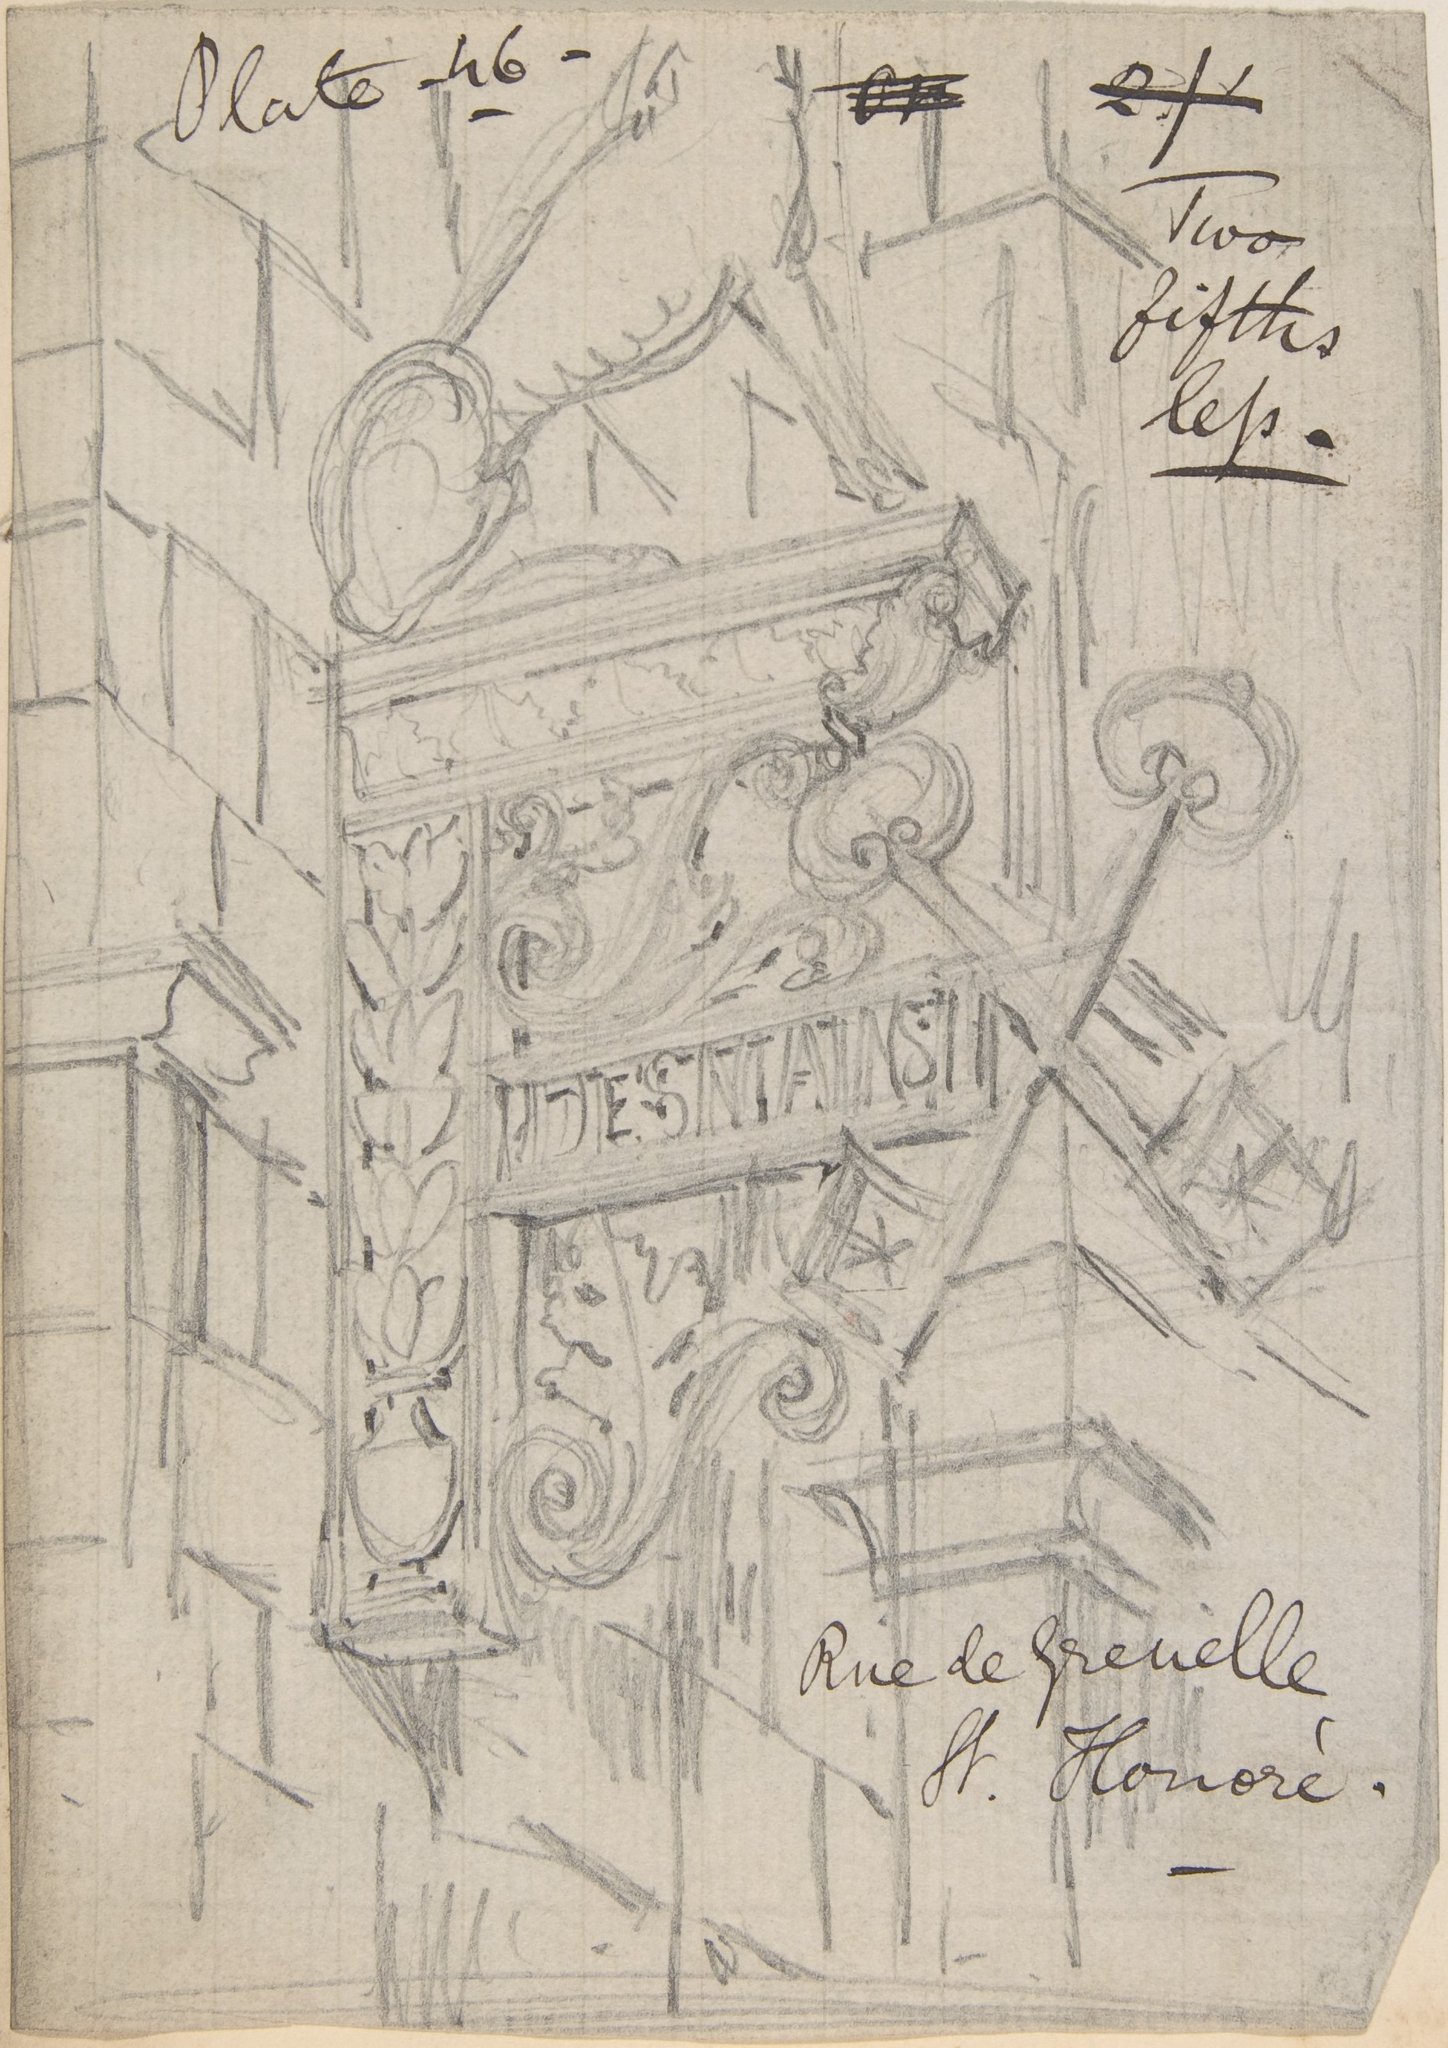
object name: drawing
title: Metal Bracket, Rue de Grenelle, St. Honoré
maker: anonymous, british, 19th century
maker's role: artist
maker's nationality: british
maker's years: 1800-1900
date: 1851-1900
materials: graphite